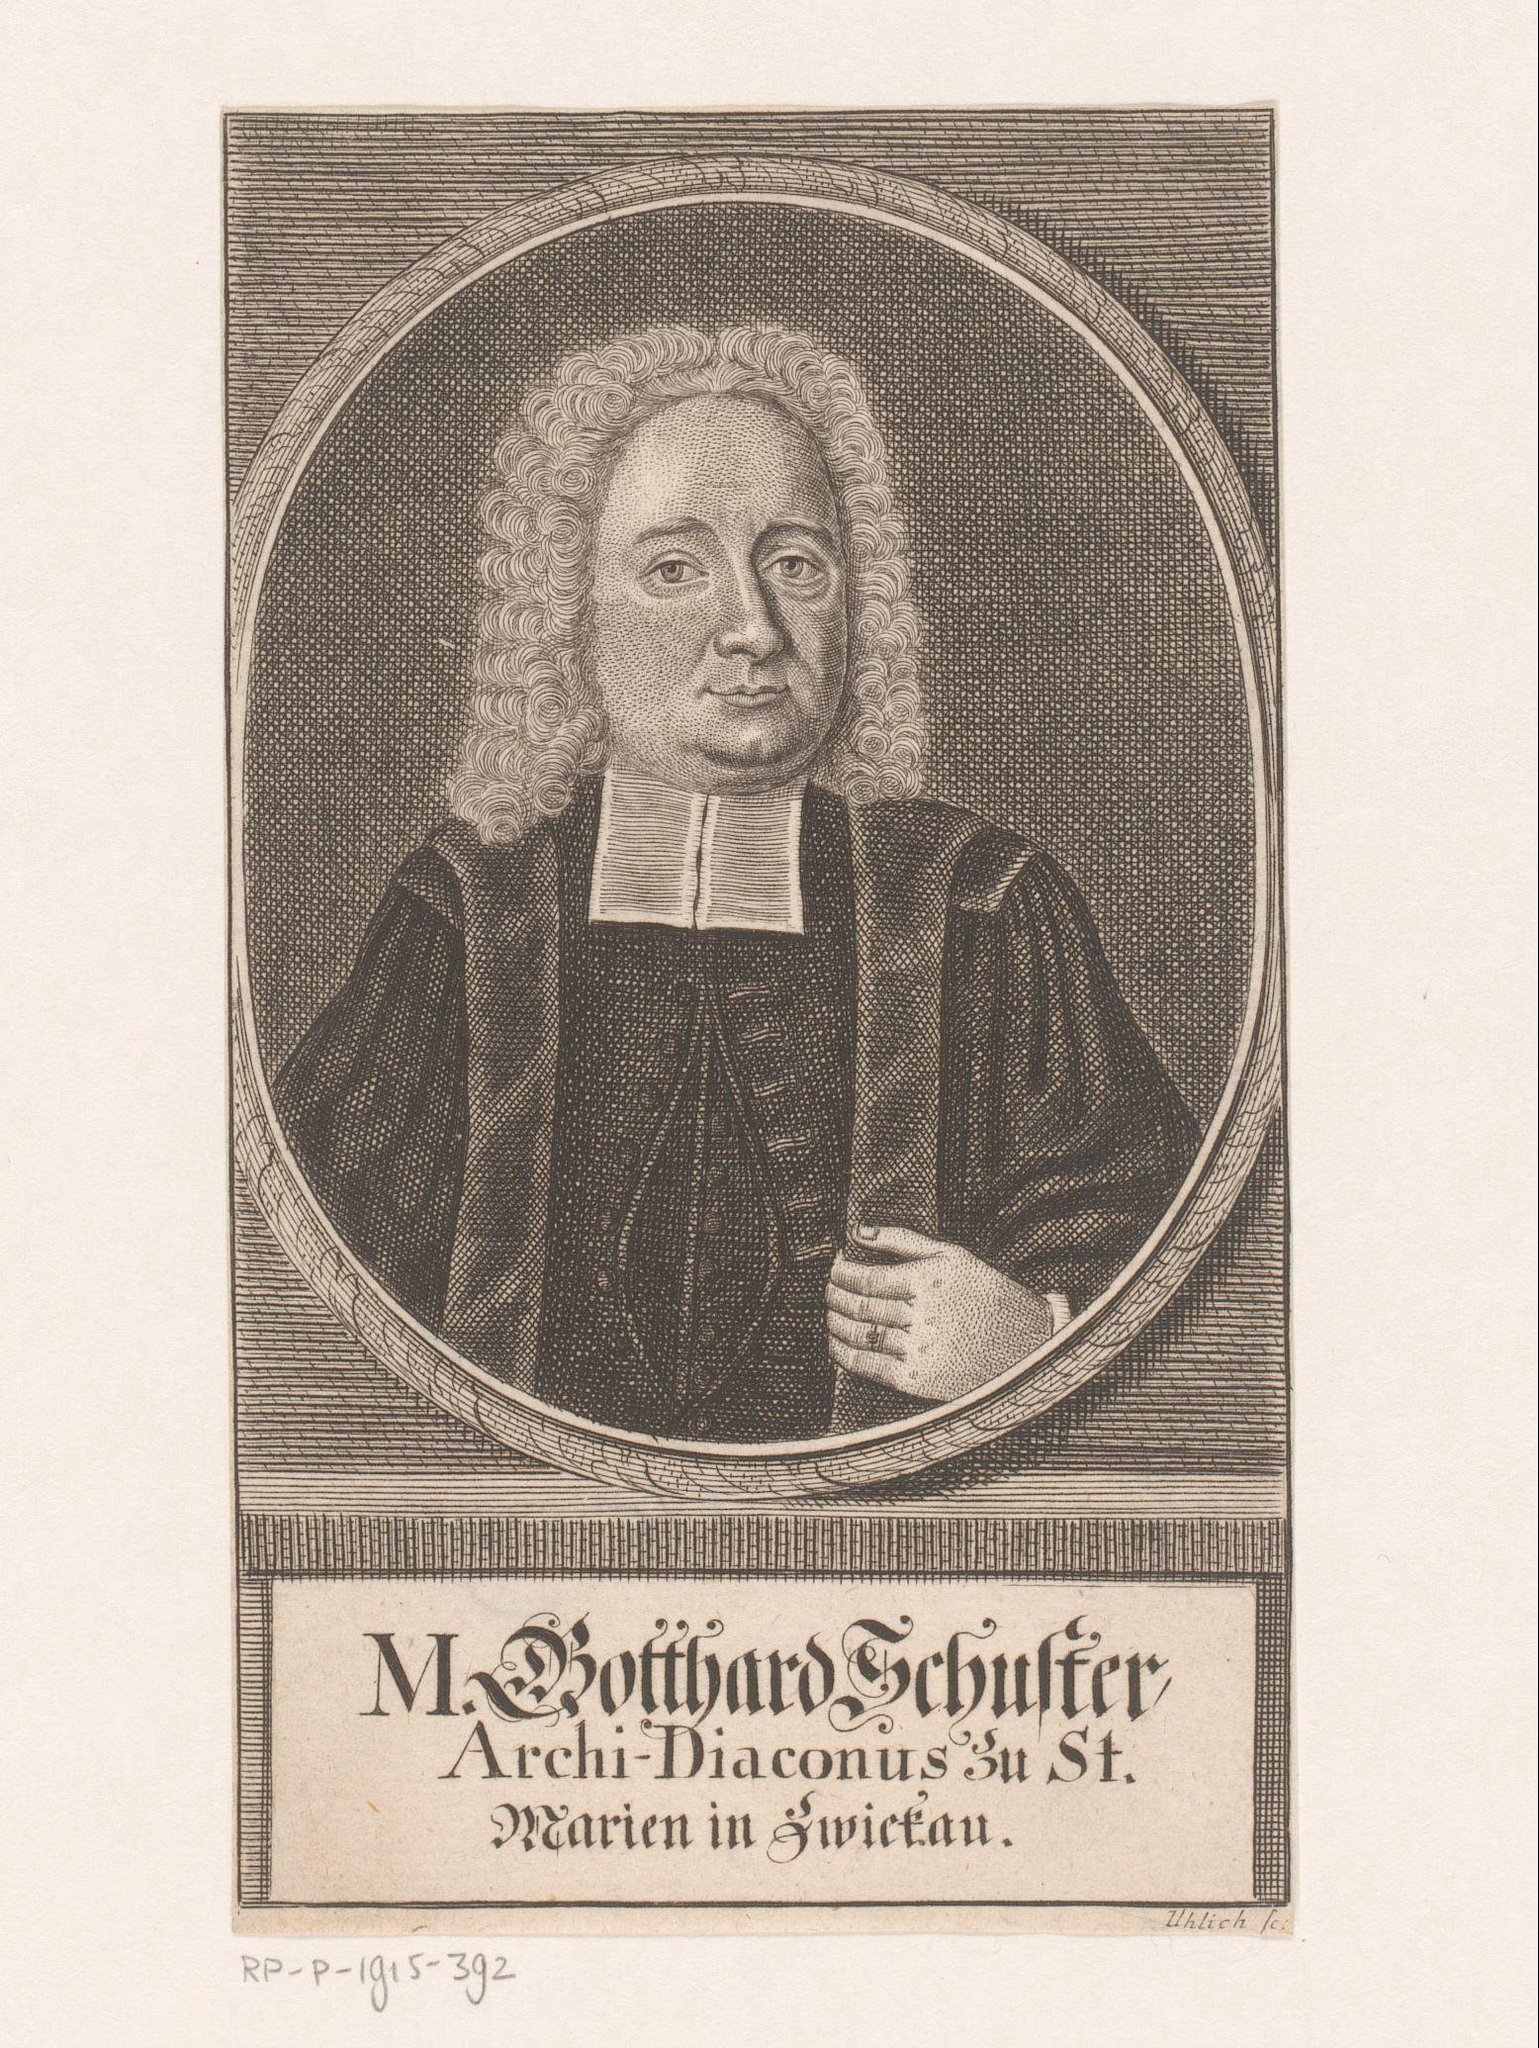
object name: print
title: Portret van Gotthard Schuster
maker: gabriel uhlich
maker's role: print maker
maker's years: 1682-1741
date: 1700-1741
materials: paper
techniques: engraving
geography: germany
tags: zwickau, historical persons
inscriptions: collector's mark: Lugt 2228